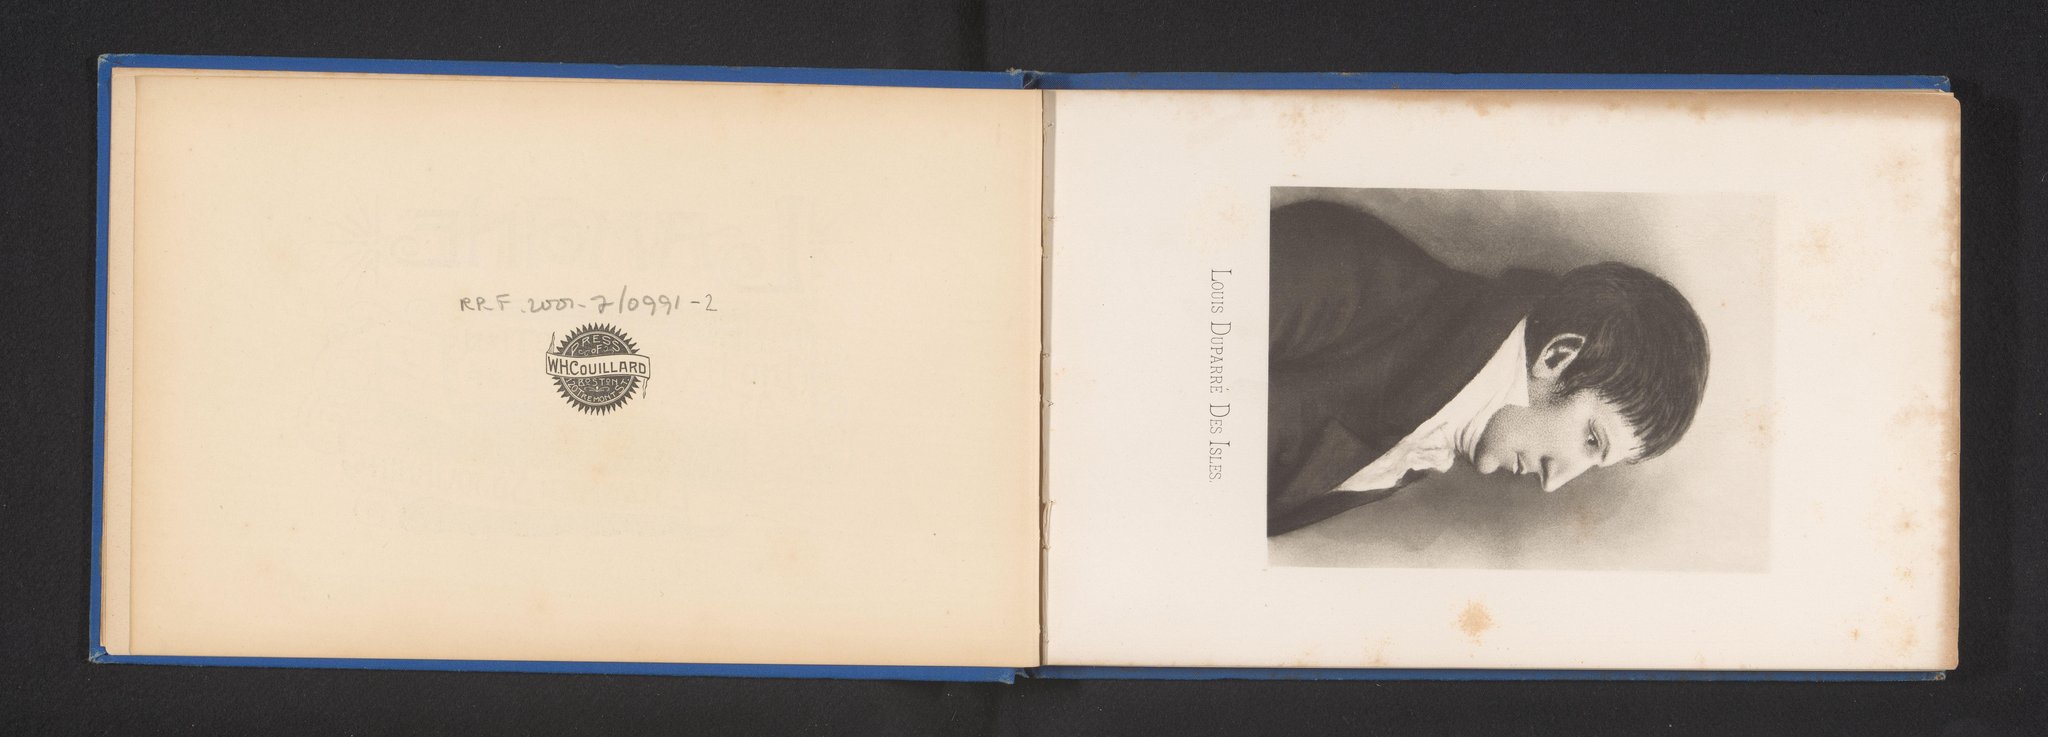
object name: reproduction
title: Louis Duparré Des Isles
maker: Anonymous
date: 1882-1887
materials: paper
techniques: photograph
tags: historical persons